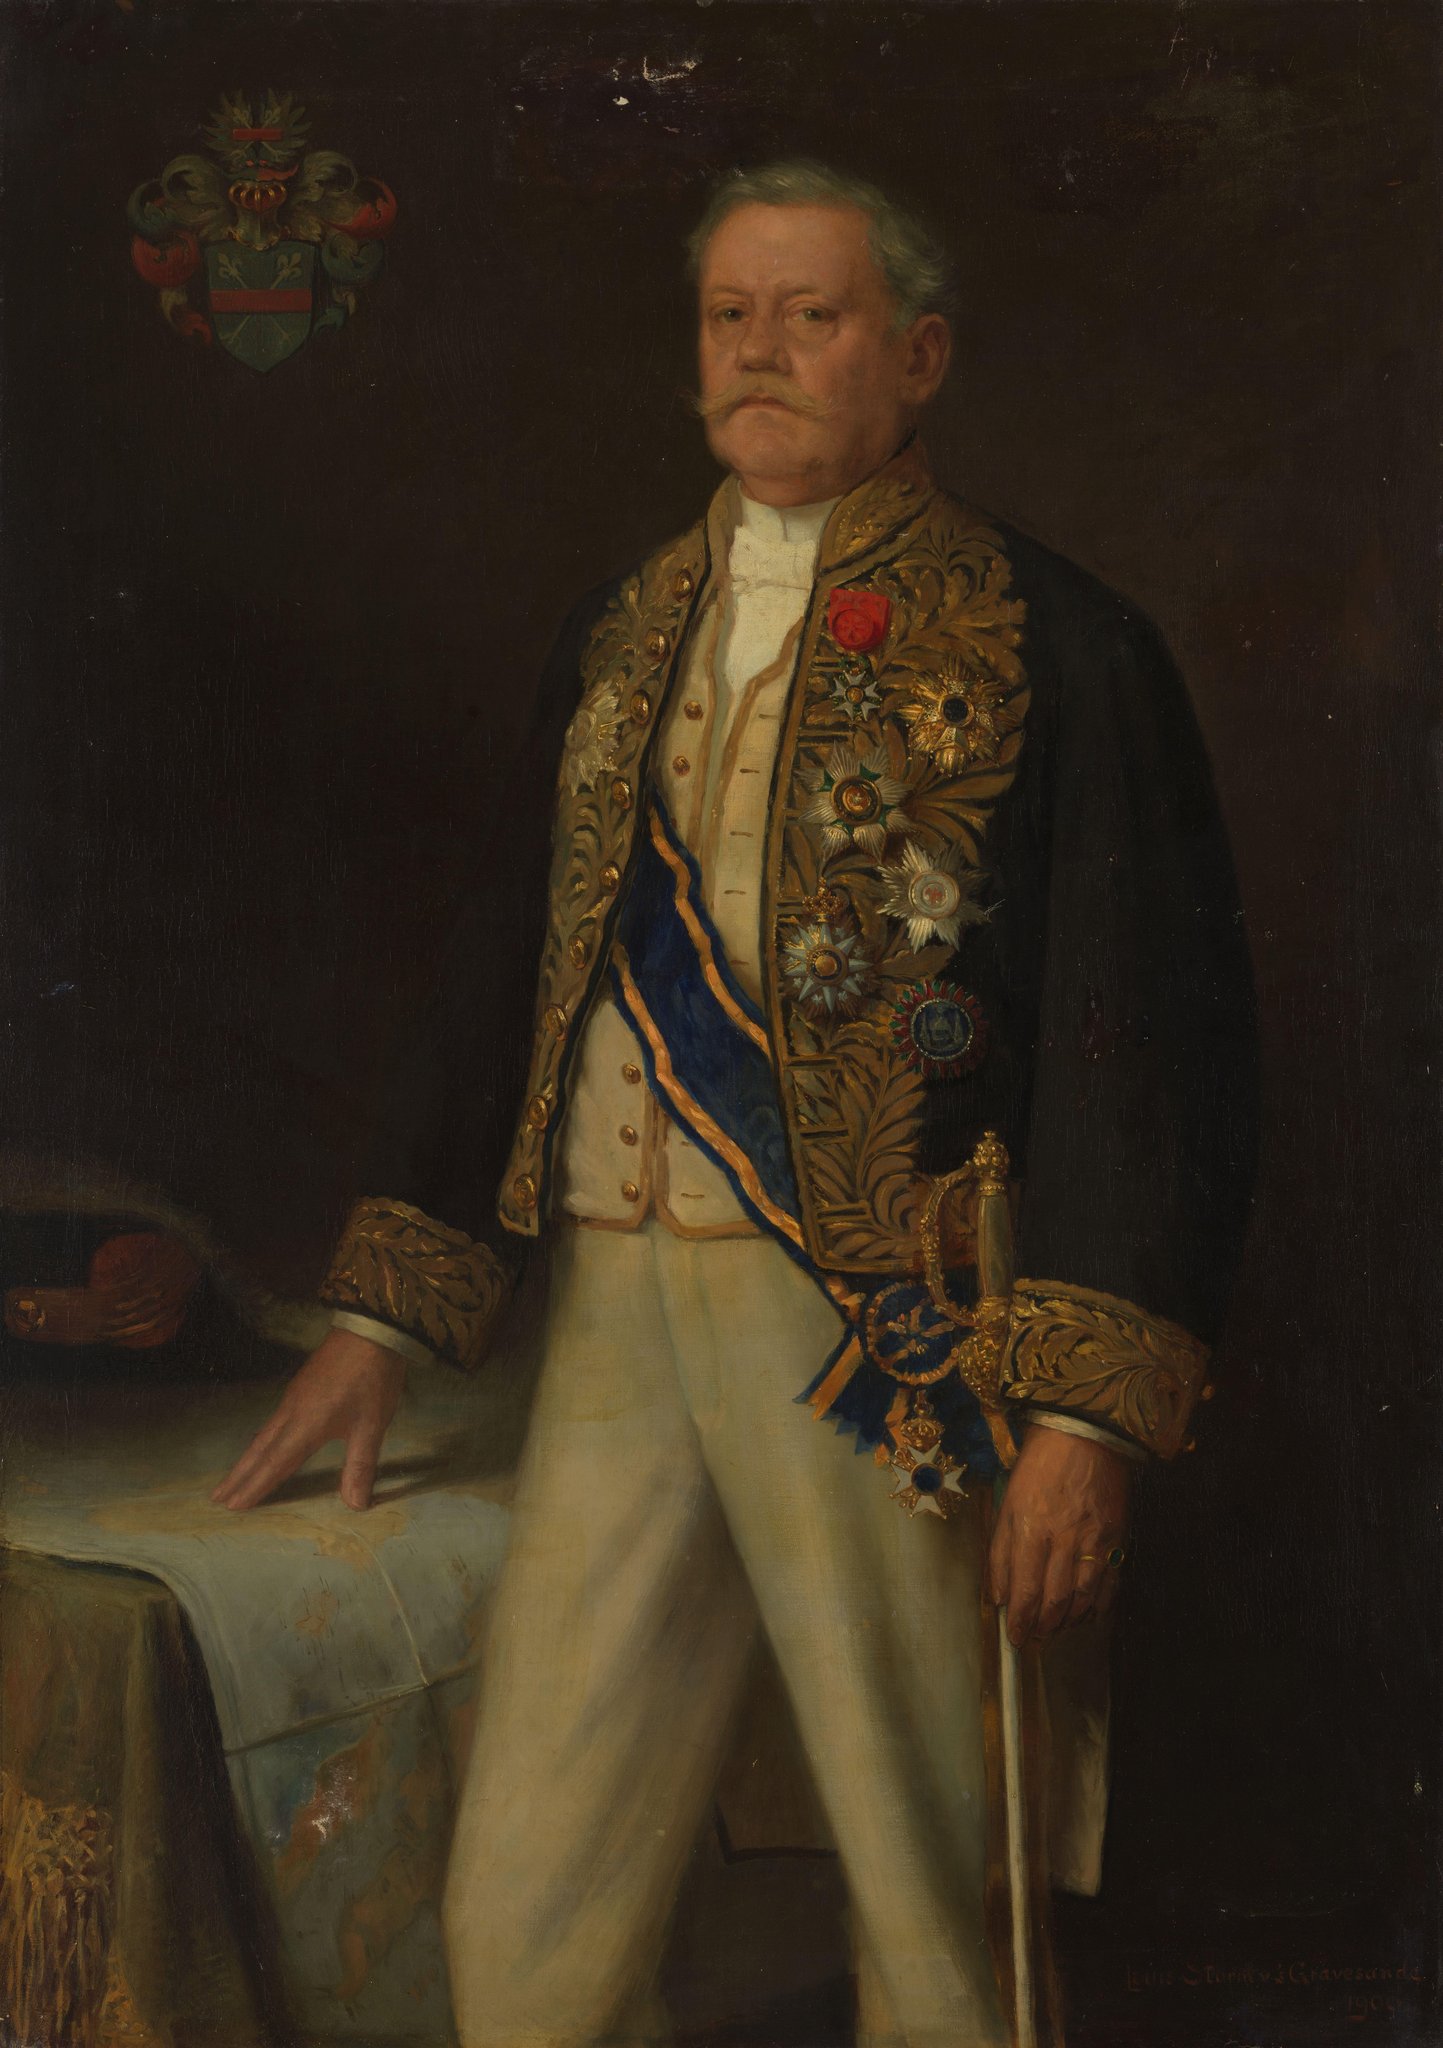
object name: painting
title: Carel Herman Aart van der Wijck (1840-1914). Gouverneur-generaal (1893-99)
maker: louis storm van s-gravensande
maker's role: painter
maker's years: 1861-1930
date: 1900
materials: canvas, oil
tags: colonial governor, historical persons, dutch east indies, the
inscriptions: signature and date: ‘Louis Storm v. 's Gravesande’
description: Portret van Carel Herman Aart van der Wijck (1840-1914). Gouverneur-generaal (1893-99). Kniestuk, staande met de rechterhand rustend op een opengevouwen landkaart van Indië op een tafel. Linksboven het familiewapen. Onderdeel van een reeks van portretten van de gouverneurs-generaal van het voormalige Nederlands Oost-Indië.